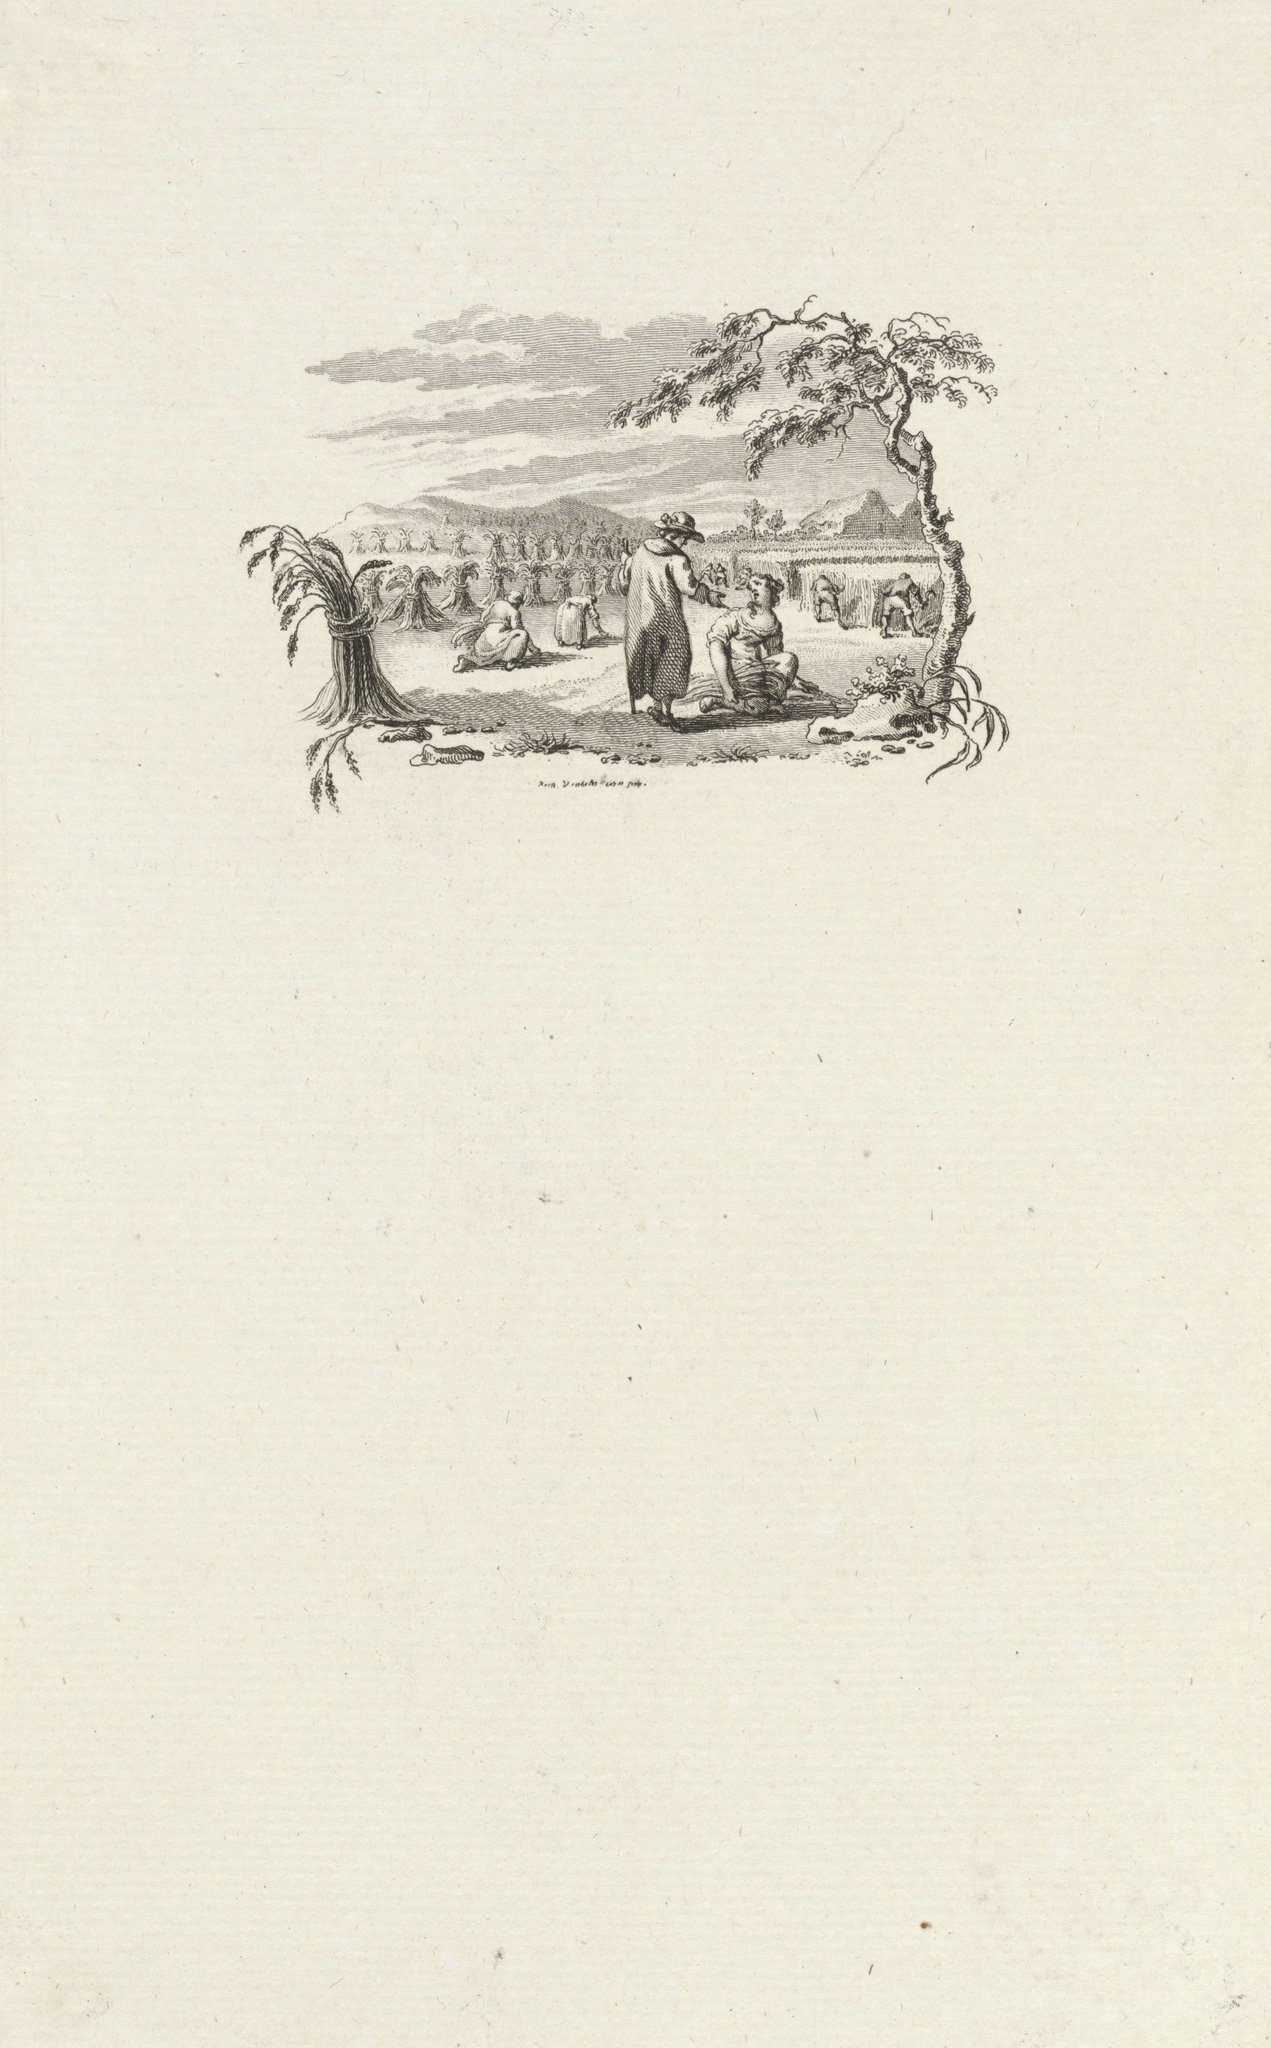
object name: print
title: Vignet met een voor een man geknielde vrouw en boeren die op het land werken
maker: reinier vinkeles (i)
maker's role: draughtsman, print maker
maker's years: 1741-1816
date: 1751-1816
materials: paper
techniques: engraving, etching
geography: amsterdam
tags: harvest, meadow, pasture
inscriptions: collector's mark: Lugt 240